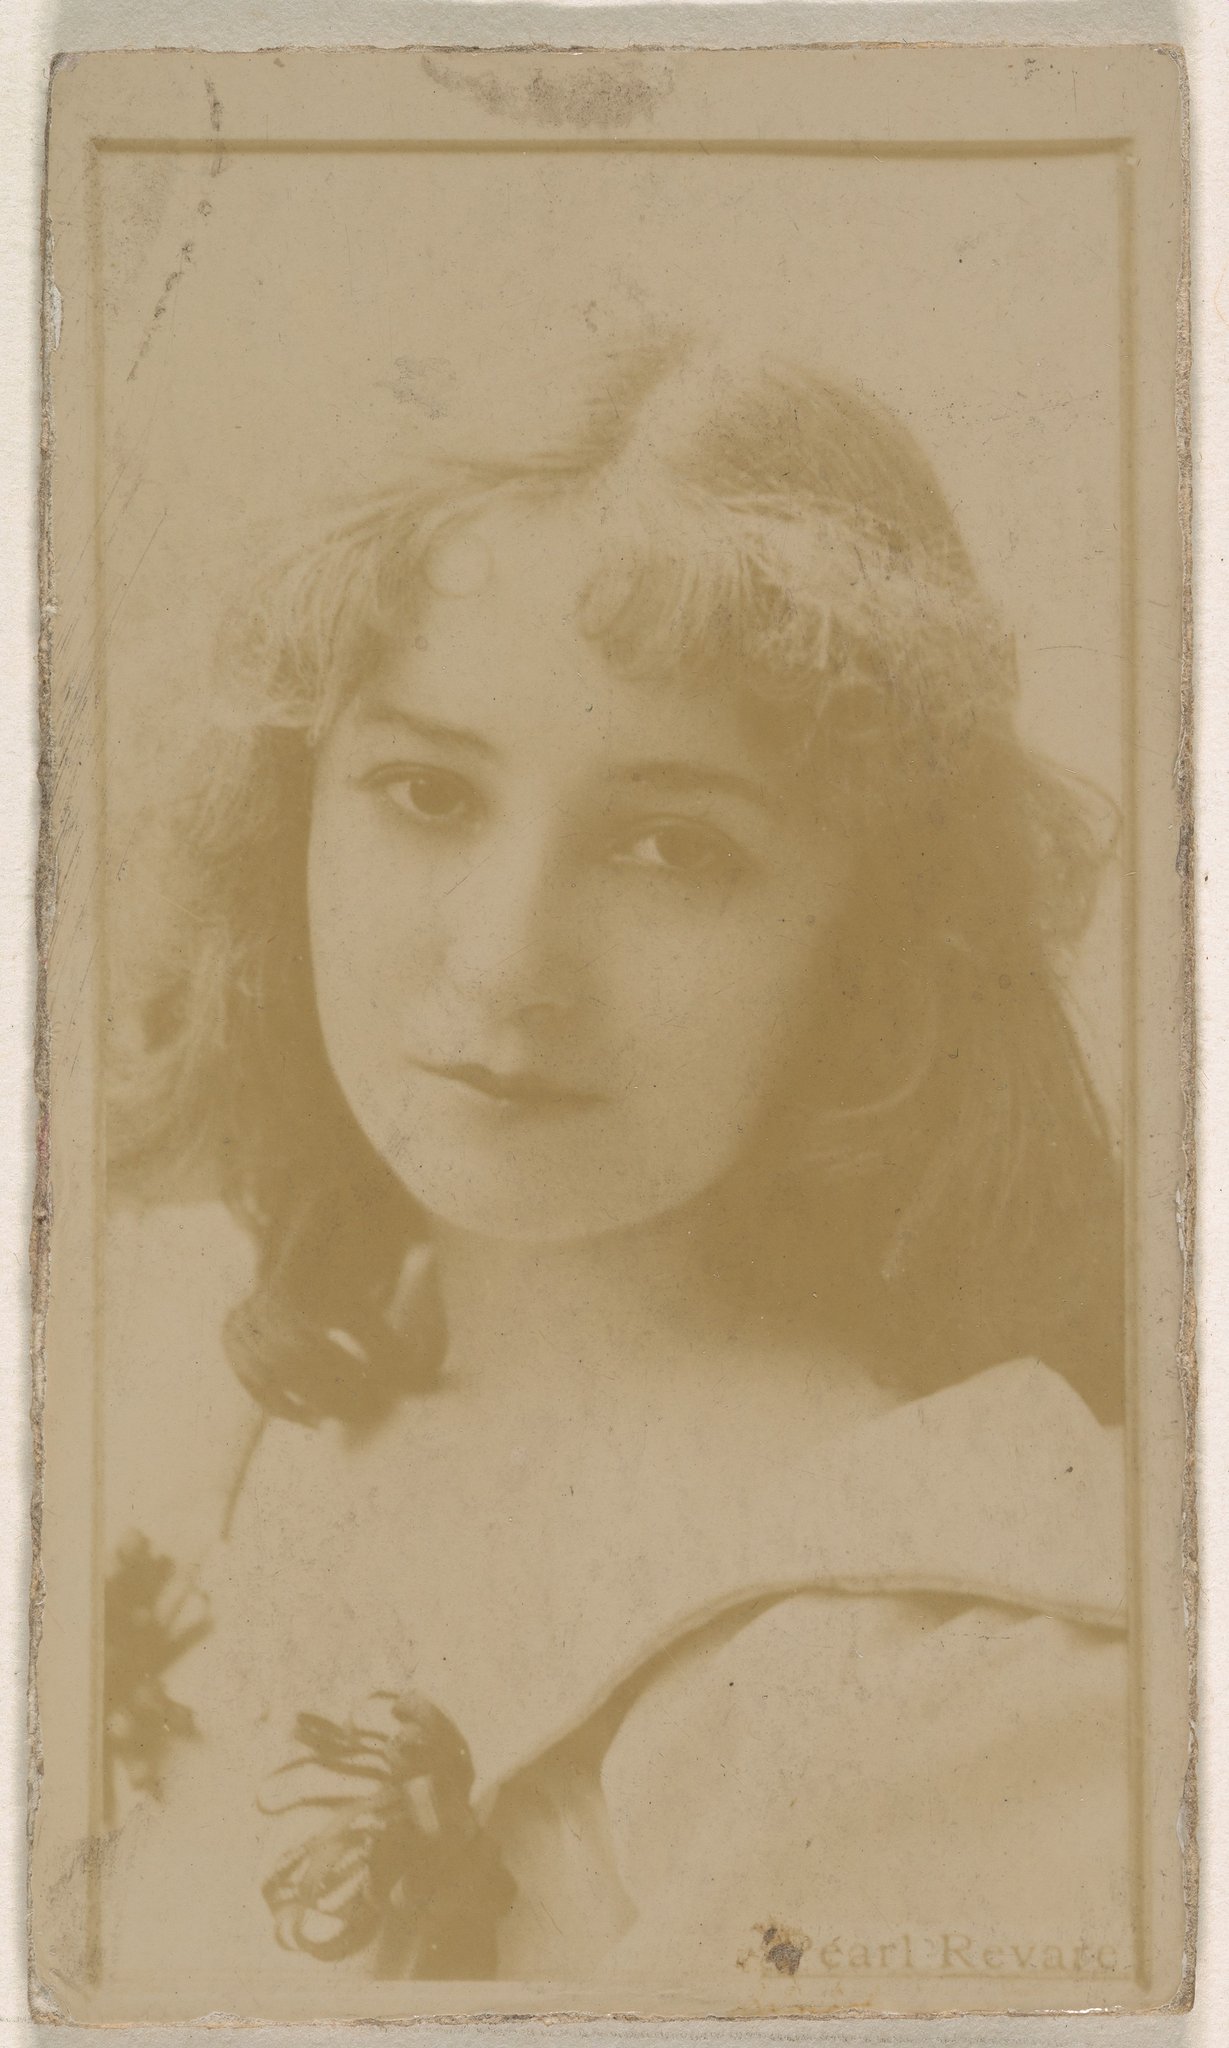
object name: photograph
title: Pearl Revare, from the Actresses series (N245) issued by Kinney Brothers to promote Sweet Caporal Cigarettes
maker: kinney brothers tobacco company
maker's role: publisher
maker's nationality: american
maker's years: 1869-2011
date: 1890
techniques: albumen silver print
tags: portraits,women,actresses